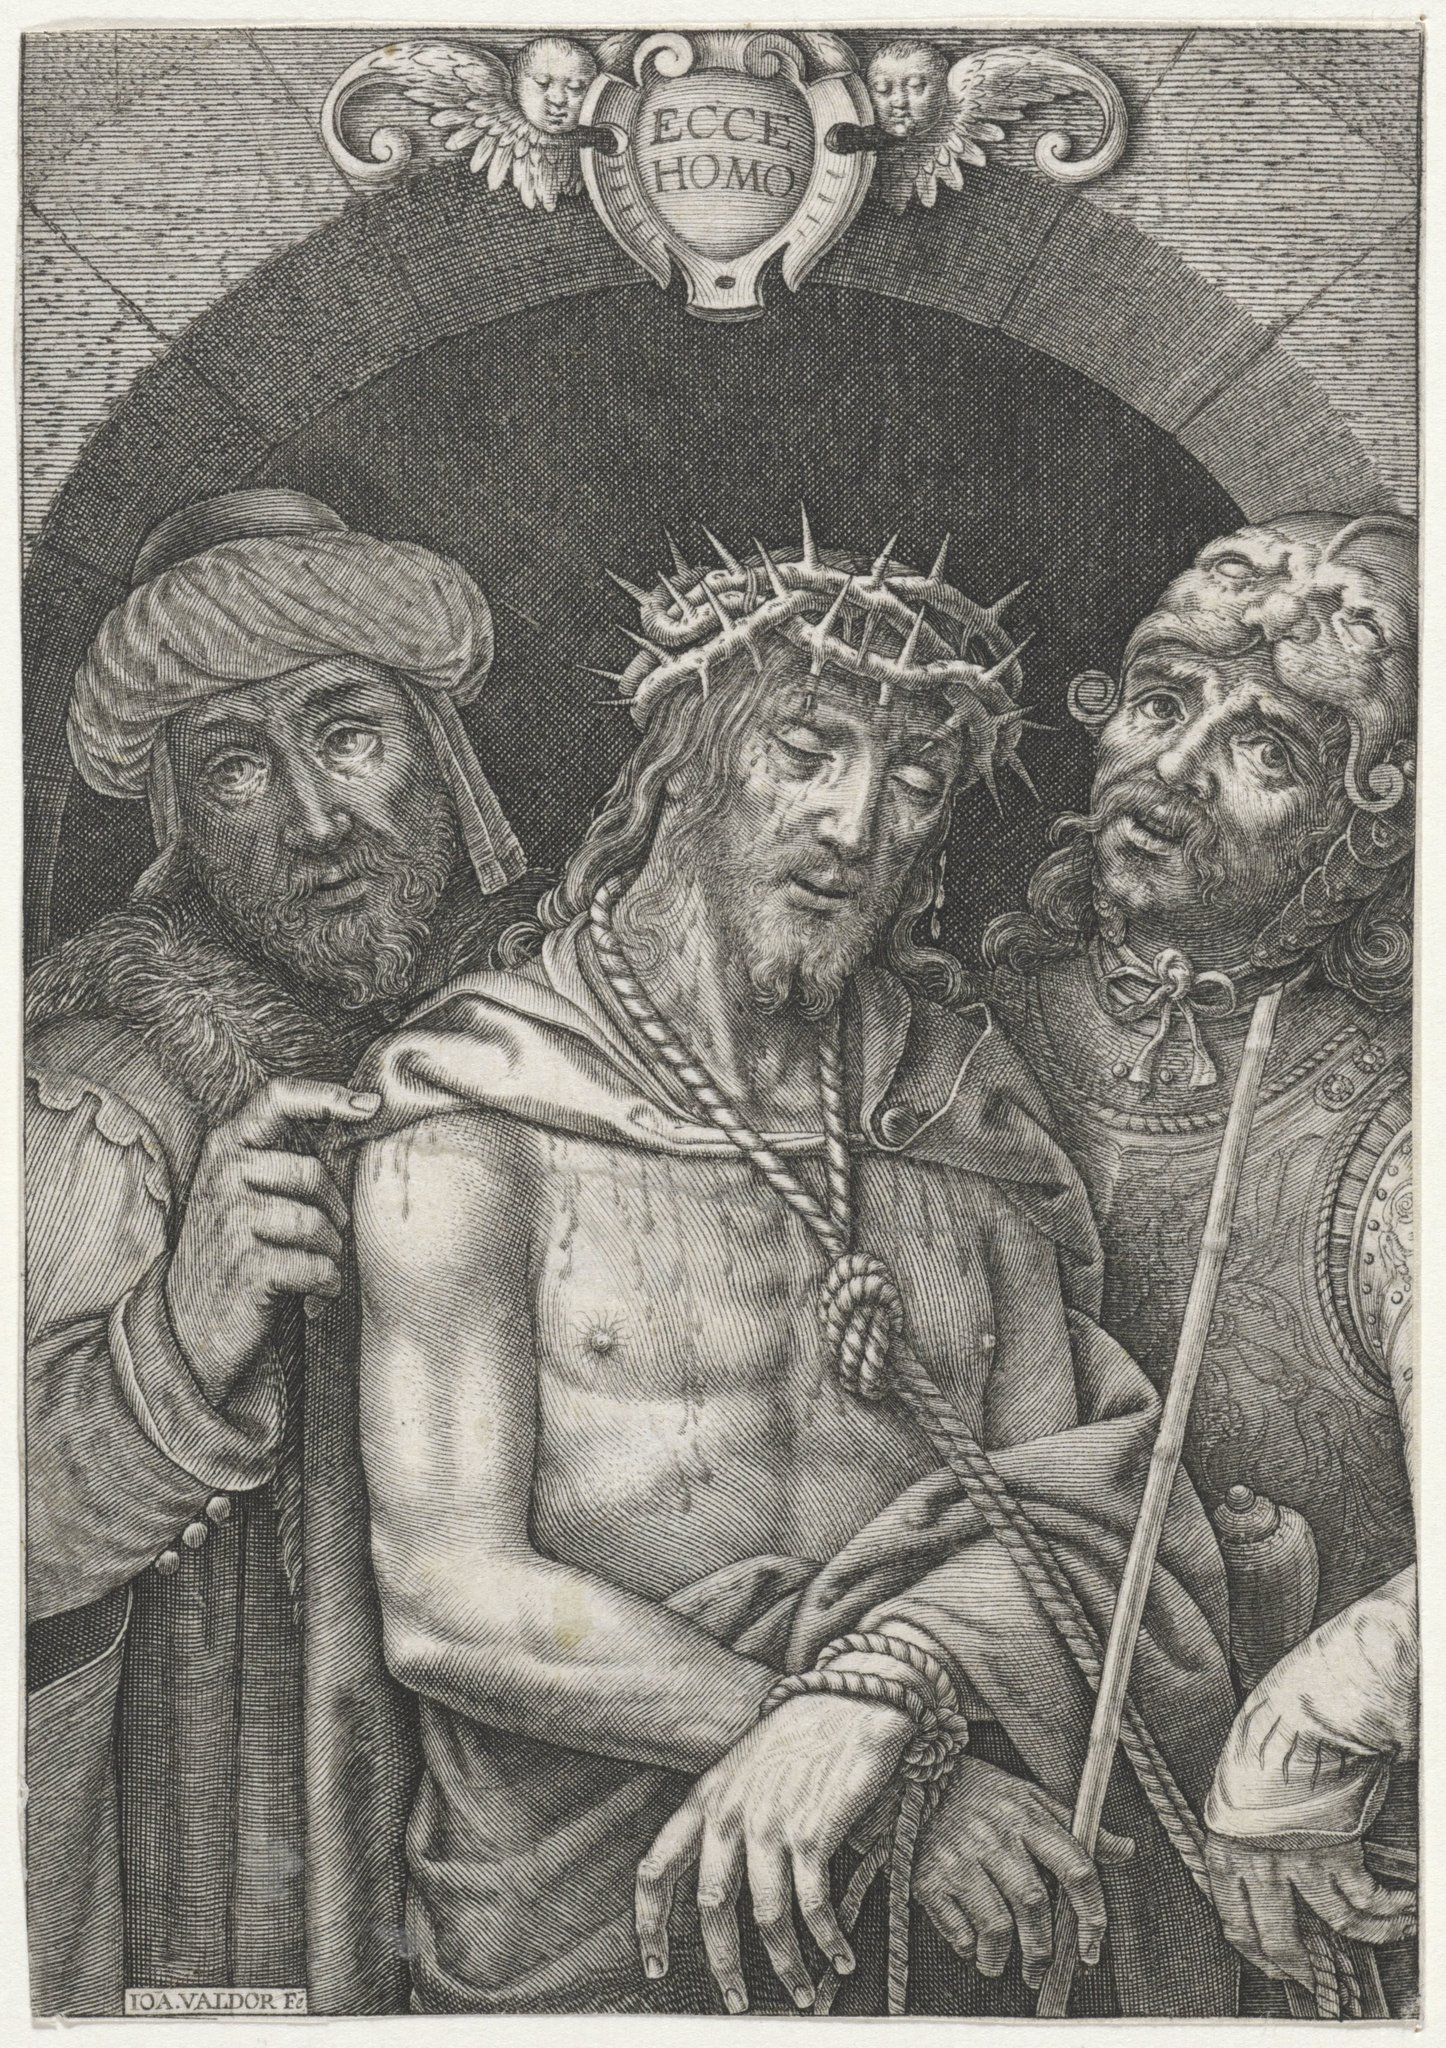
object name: print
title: Ecce Homo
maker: johannes valdor (i)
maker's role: print maker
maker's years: 1580-1640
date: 1590-1645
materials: paper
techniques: engraving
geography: southern netherlands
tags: pilate showing christ to the people, 'ostentatio christi', 'ecce homo' (john 19:4-6)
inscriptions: collector's mark: Lugt 2228